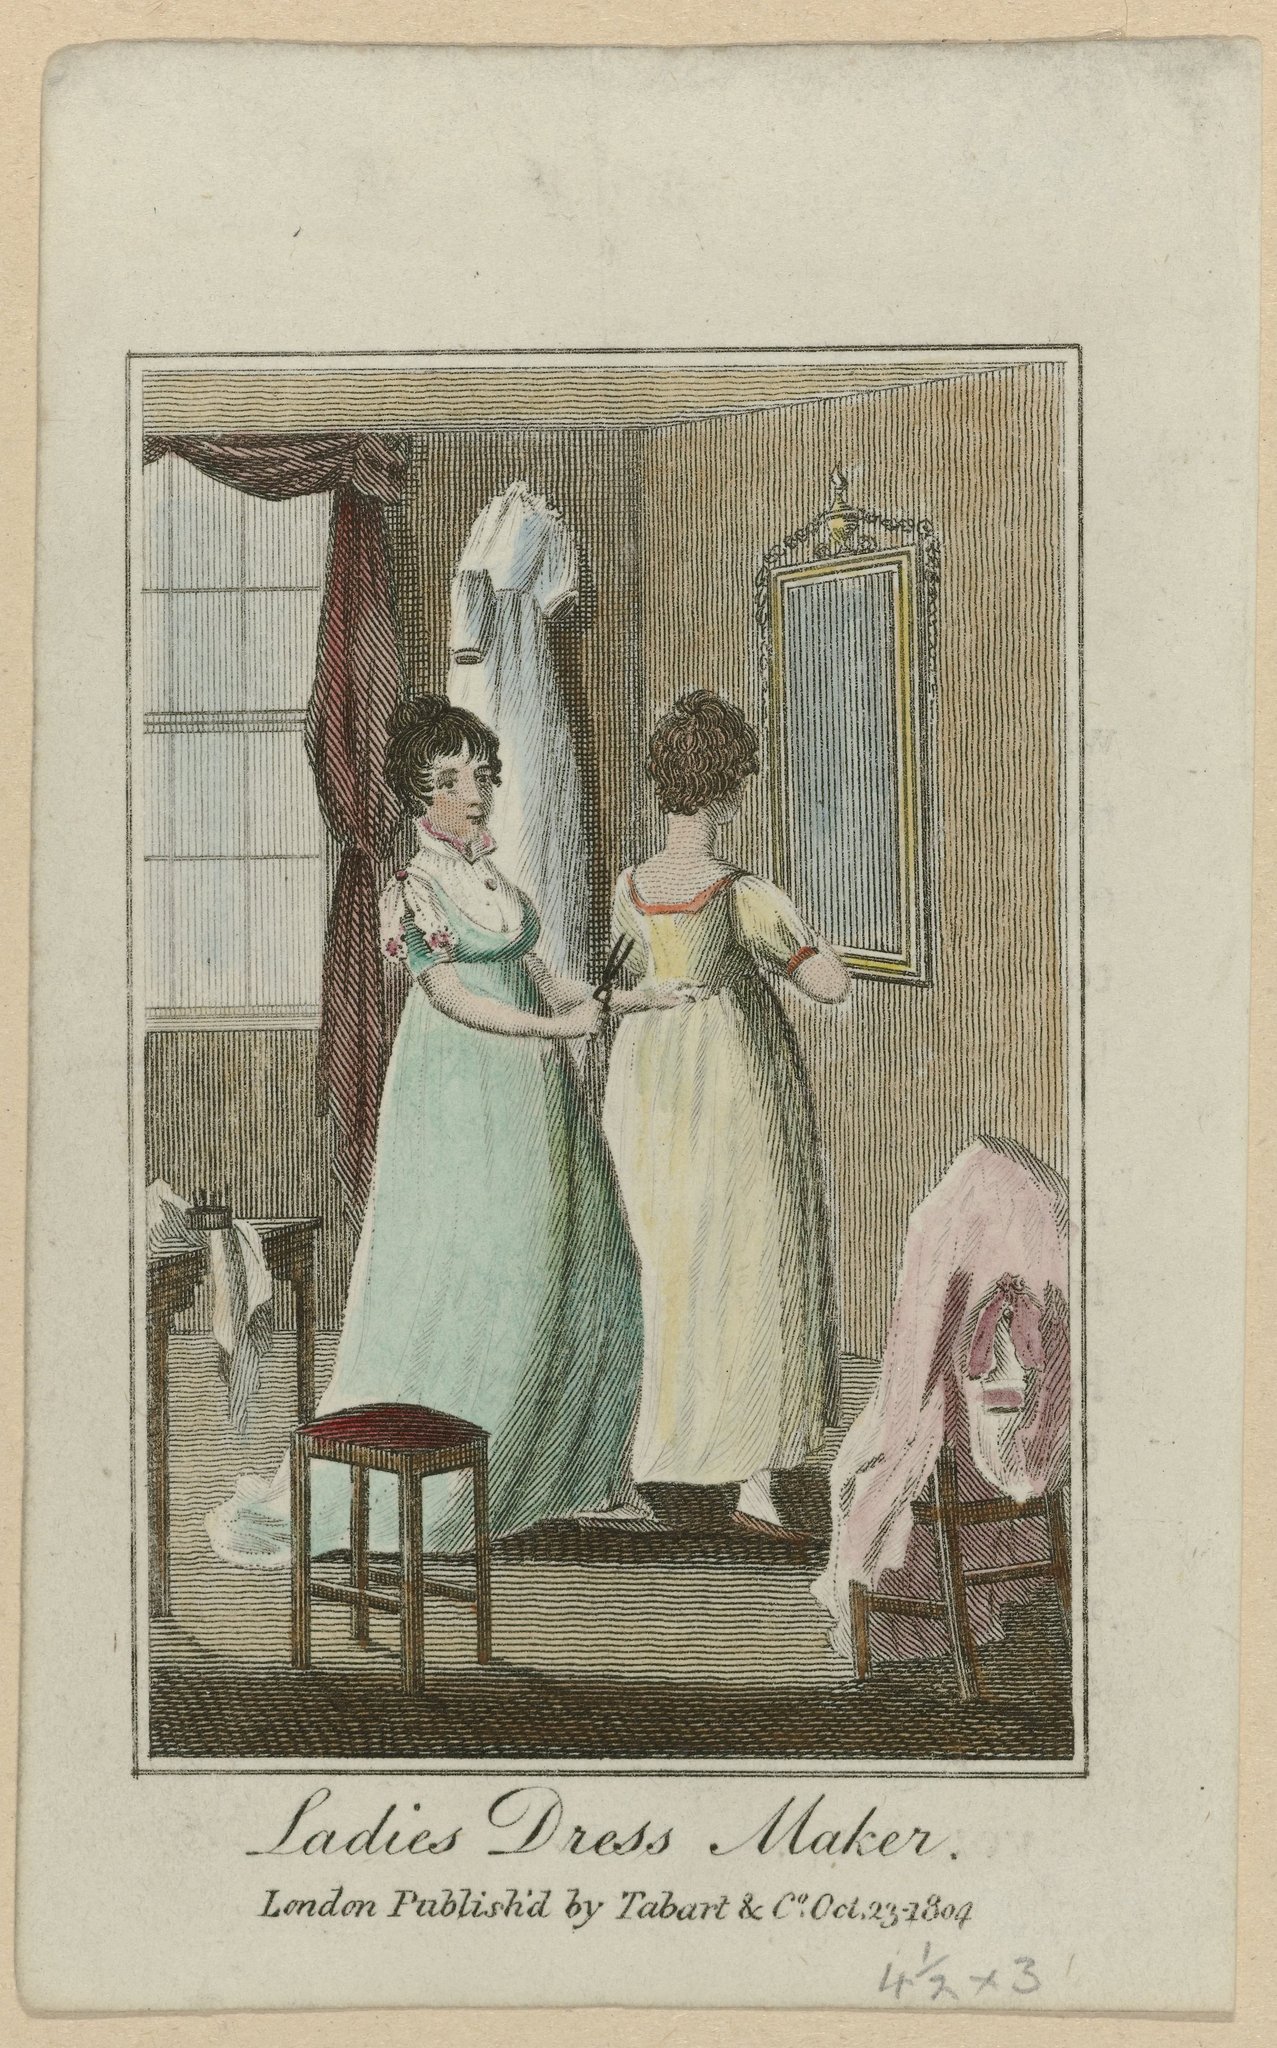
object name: fashion print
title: The Book of Trades, 23 Oct. 1804 : Ladies Dress Maker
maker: Anonymous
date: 1804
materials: paper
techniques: etching, hand coloring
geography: london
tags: fashion plates, dress, gown (+ women's clothes), tailor, dressmaker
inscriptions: caption: ‘Ladies Dress Maker. / London Publish'd by Tabart & Co. Oct. 23-1804’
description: Kleermaakster is bezig een japon op maat te maken. Zij maakt een passend patroon van de vrouw door middel van een stukje papier of stof. Het patroon vormt later de belijning van de japon. De vrouw staat naar een spiegel gekeerd. De kleermaakster draagt een japon met korte mouwen en sleep. Schaar in de hand.